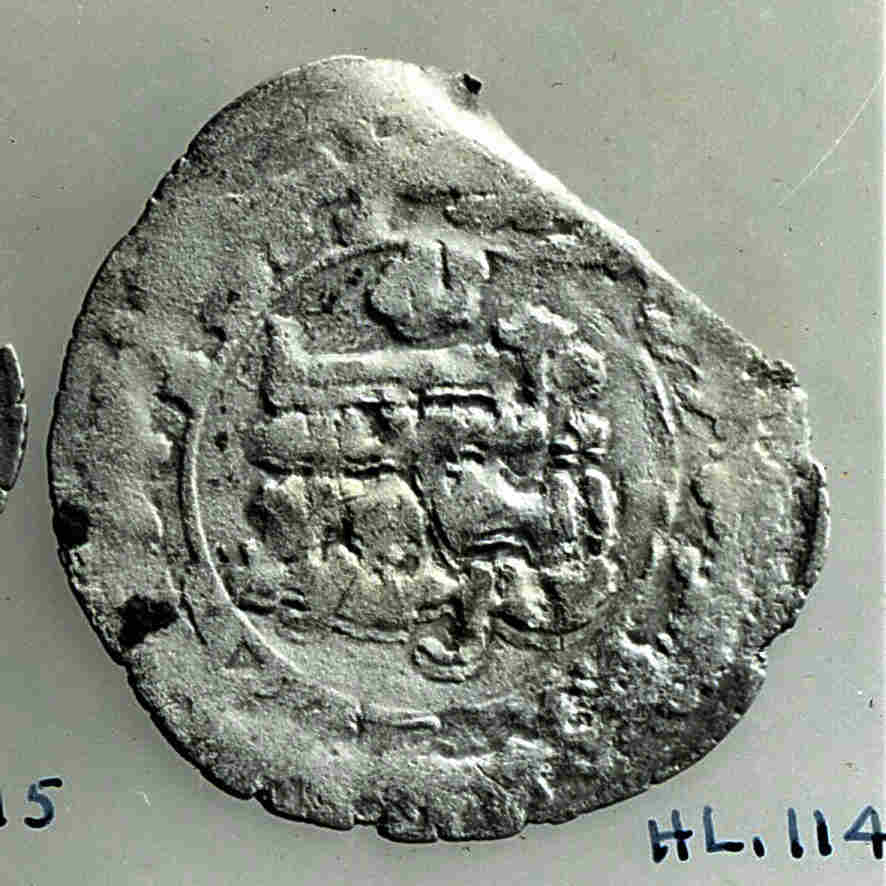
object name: coin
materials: silver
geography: al-shash